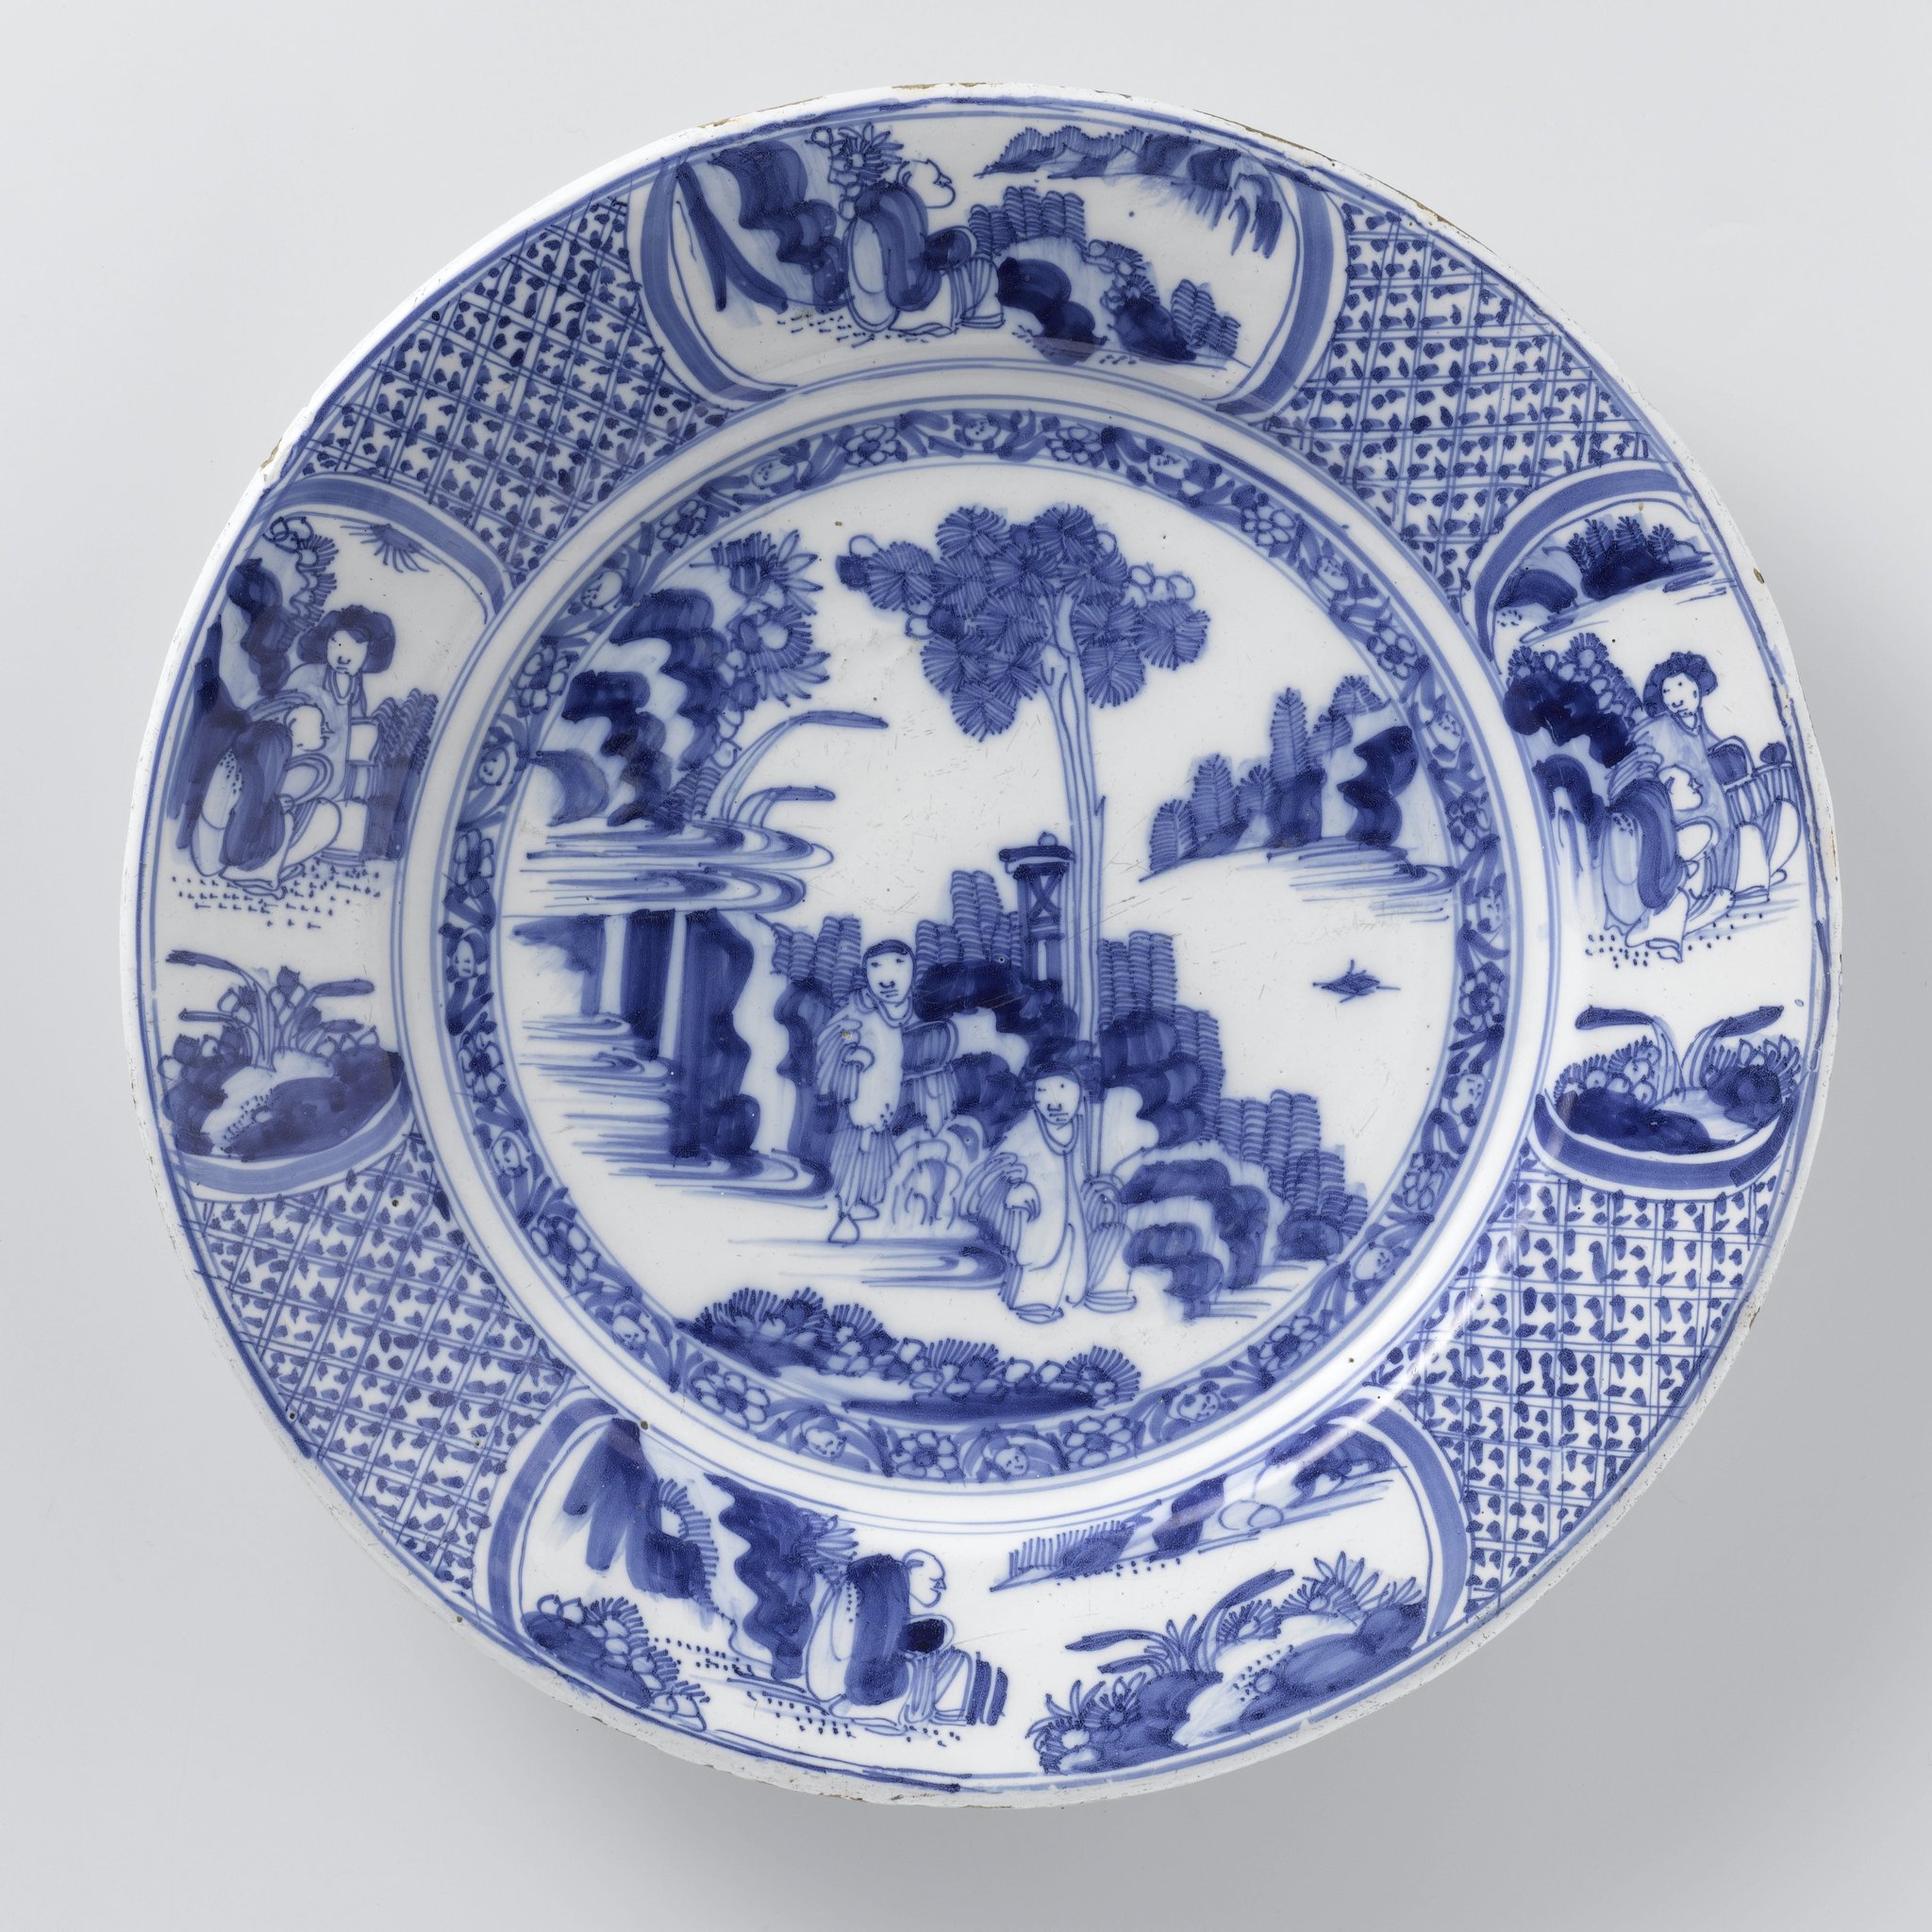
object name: platter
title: Schotel, op het plat in blauw beschilderd met een landschap met boom en twee Chinese figuren. Rand versierd met vier ovalen waarin voorstellingen, op geruite grond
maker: Anonymous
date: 1650-1665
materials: earthenware, glaze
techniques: painted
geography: delft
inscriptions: inscription: ‘f 12,50’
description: Ronde schotel van blauw beschilderde faience. Op het plat is een landschap met een boom en twee figuren (Chinezen) geschilderd. De rand heeft een geruite ondergrond en vier ovale vakken. In twee van de vakken is een zittende figuur (Chinees) in een landschap geschilderd en in de andere twee vakken twee figuren (Chinezen) in een landschap.